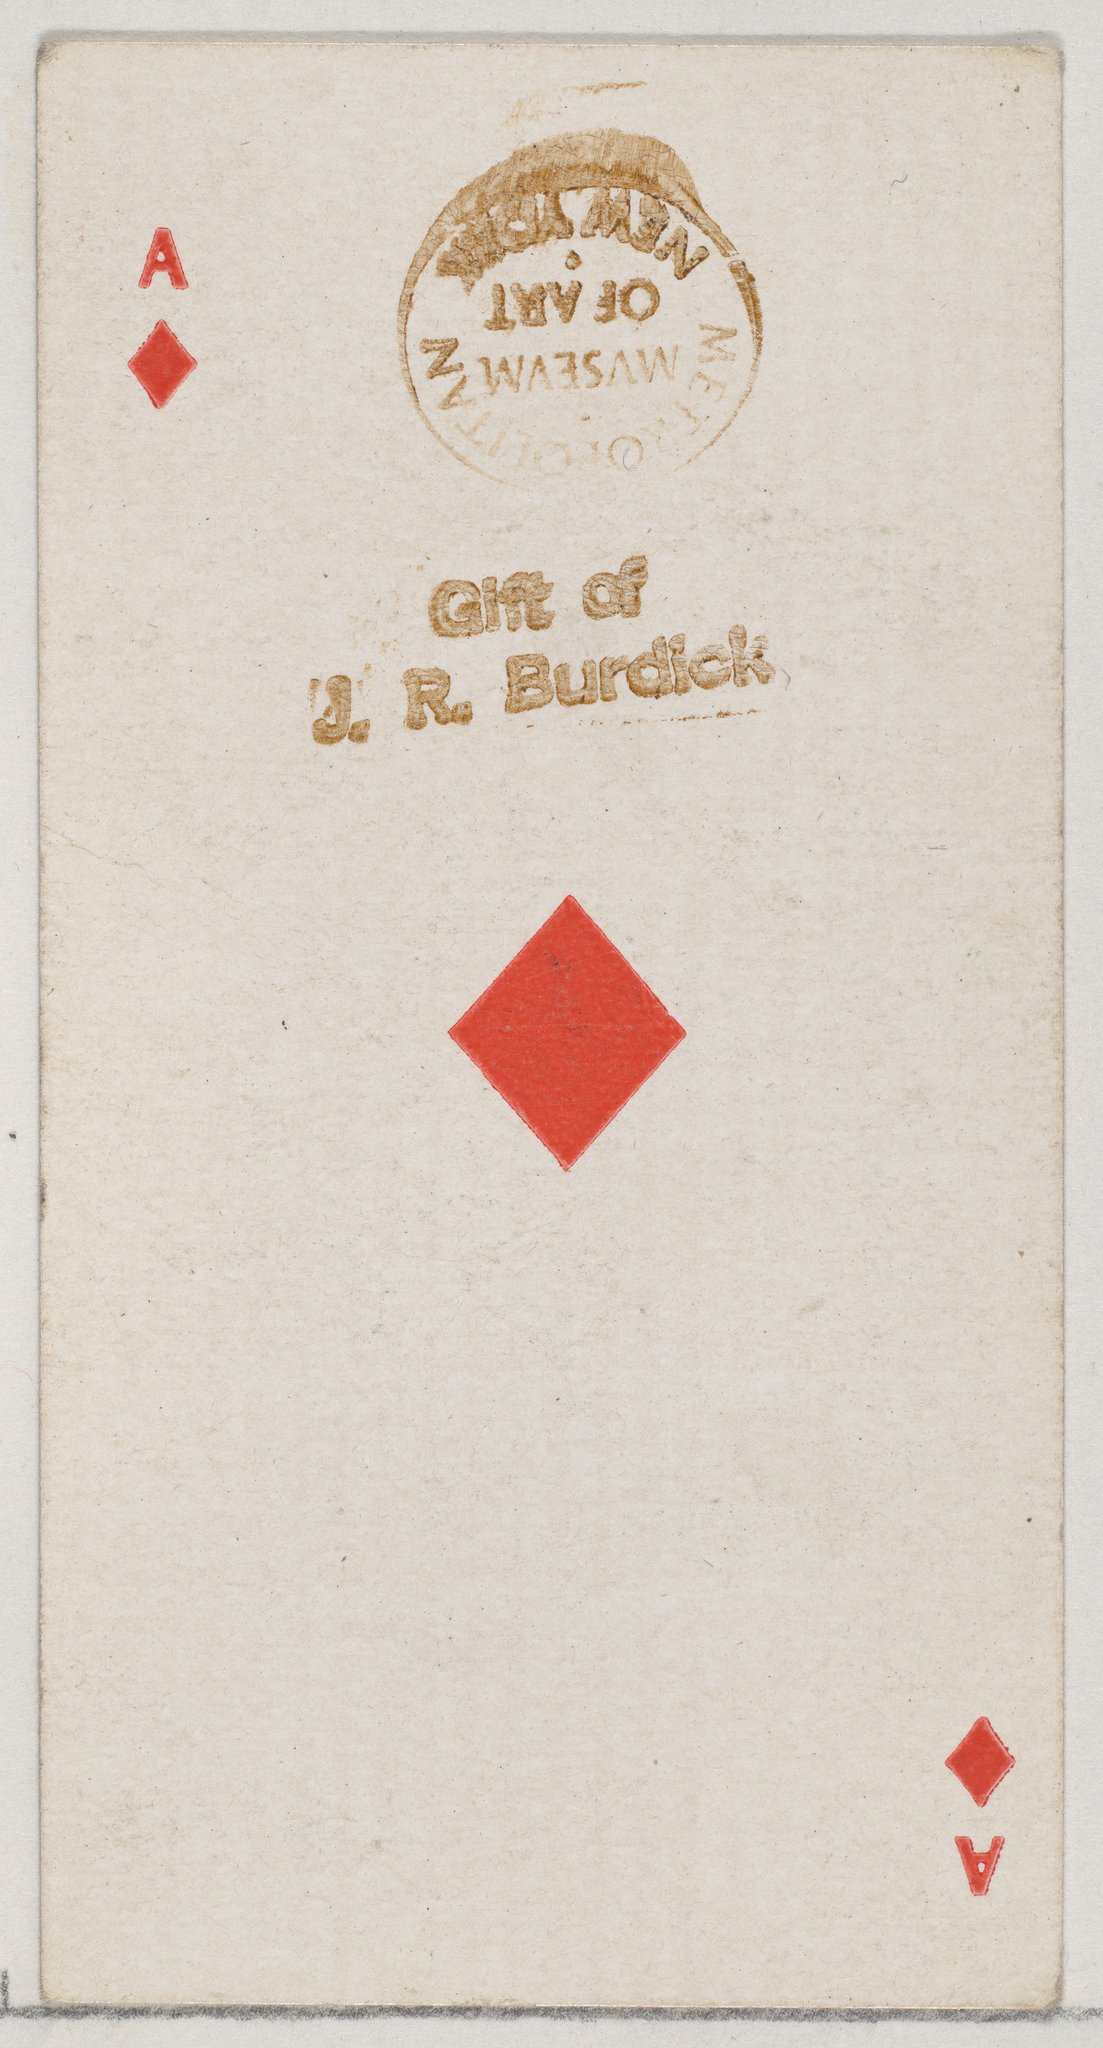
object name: print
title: Ace of Diamonds (red), from the Playing Cards series (N84) for Duke brand cigarettes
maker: w. duke, sons & co.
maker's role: publisher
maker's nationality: american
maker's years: 1870-1920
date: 1888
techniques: color lithograph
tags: playing cards